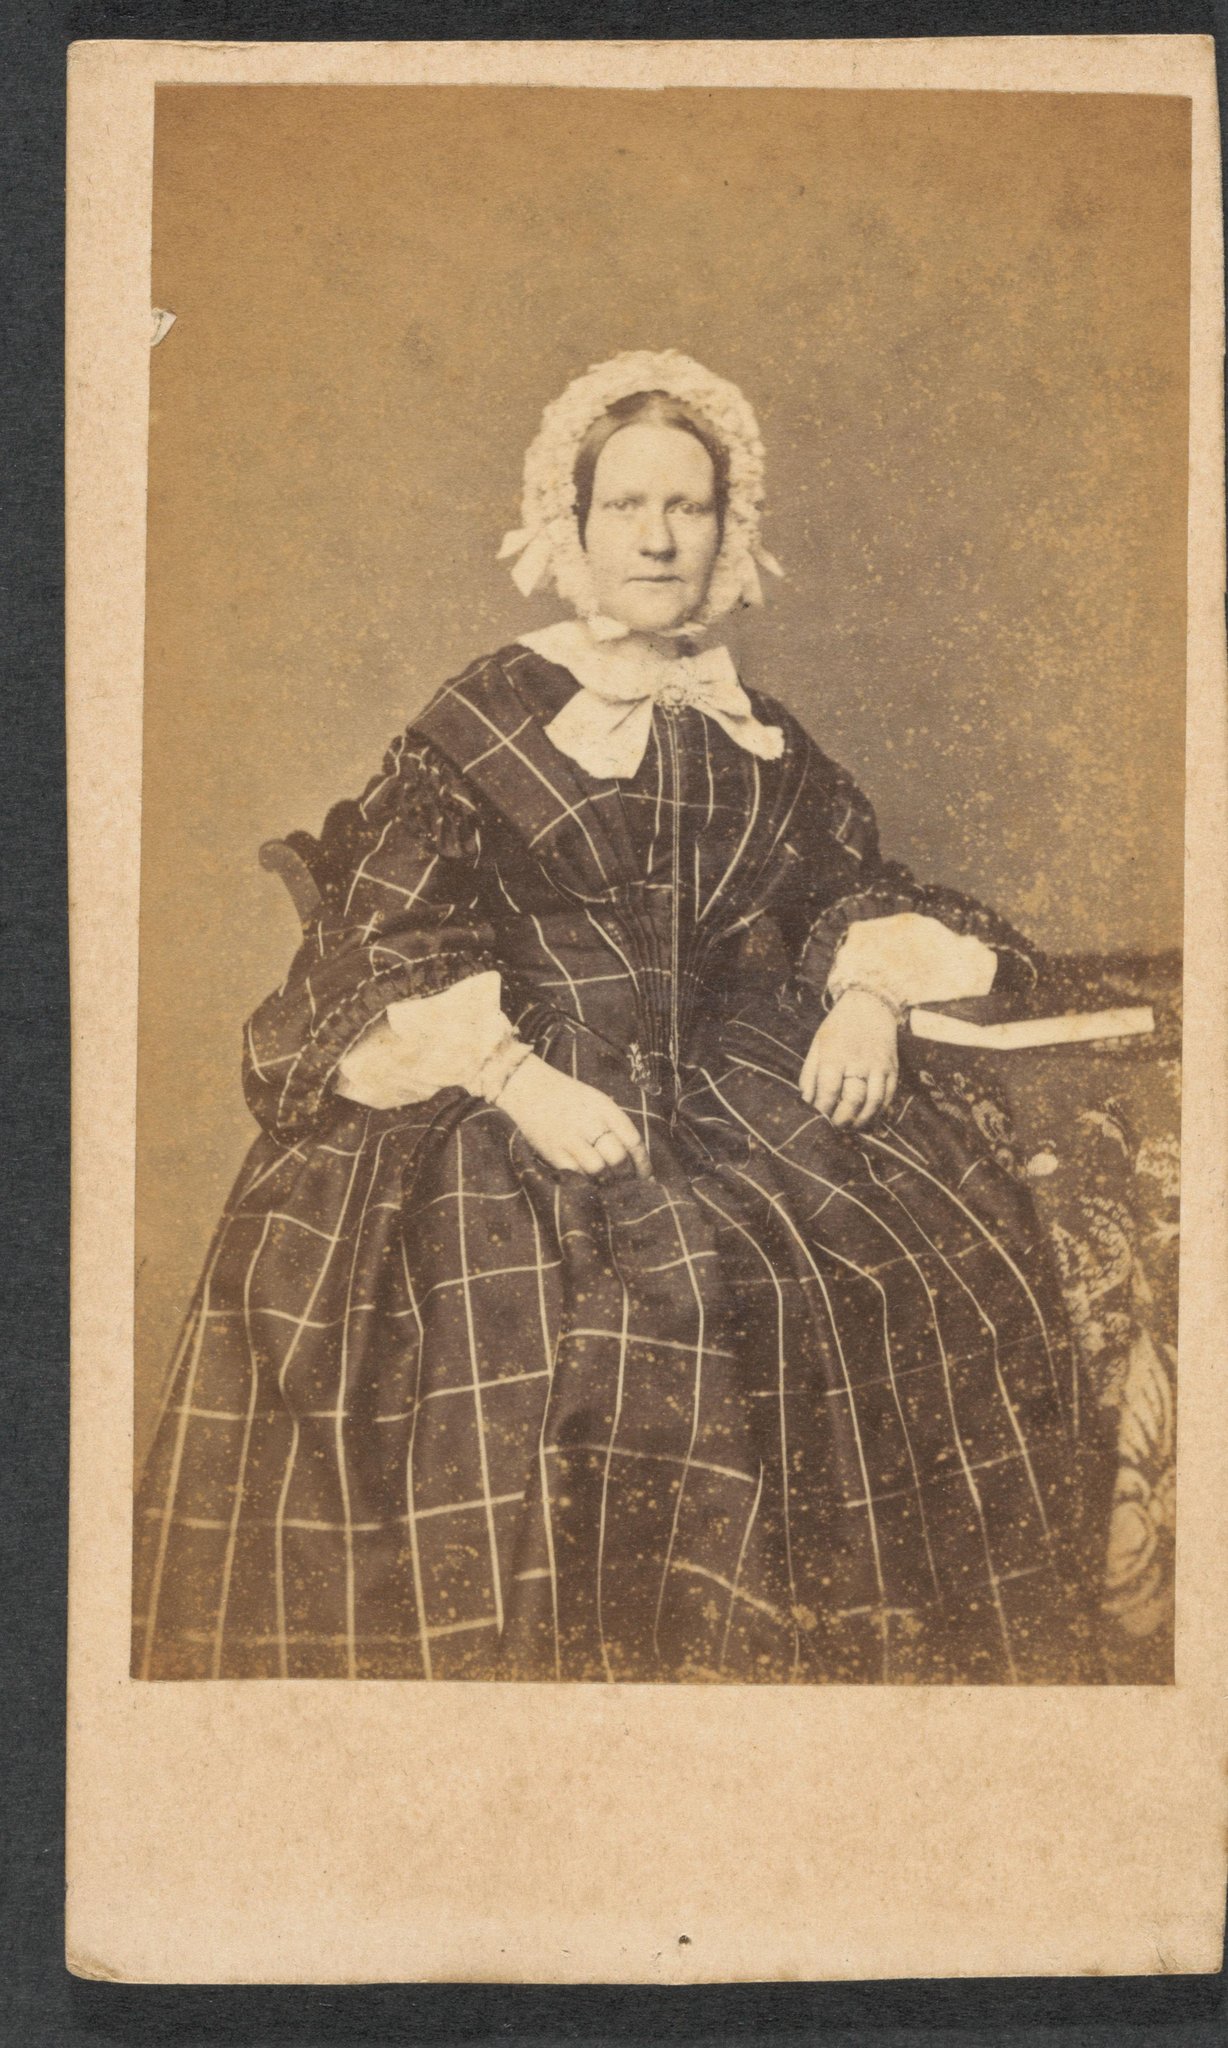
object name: carte de visite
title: Portret van een onbekende vrouw uit de familie Marmelstein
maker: cornelis johannes dirksen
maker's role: fotograaf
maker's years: 1826-1897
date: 1850-1900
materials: cardboard, photographic support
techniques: albumen print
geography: middelburg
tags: adult woman, historical persons